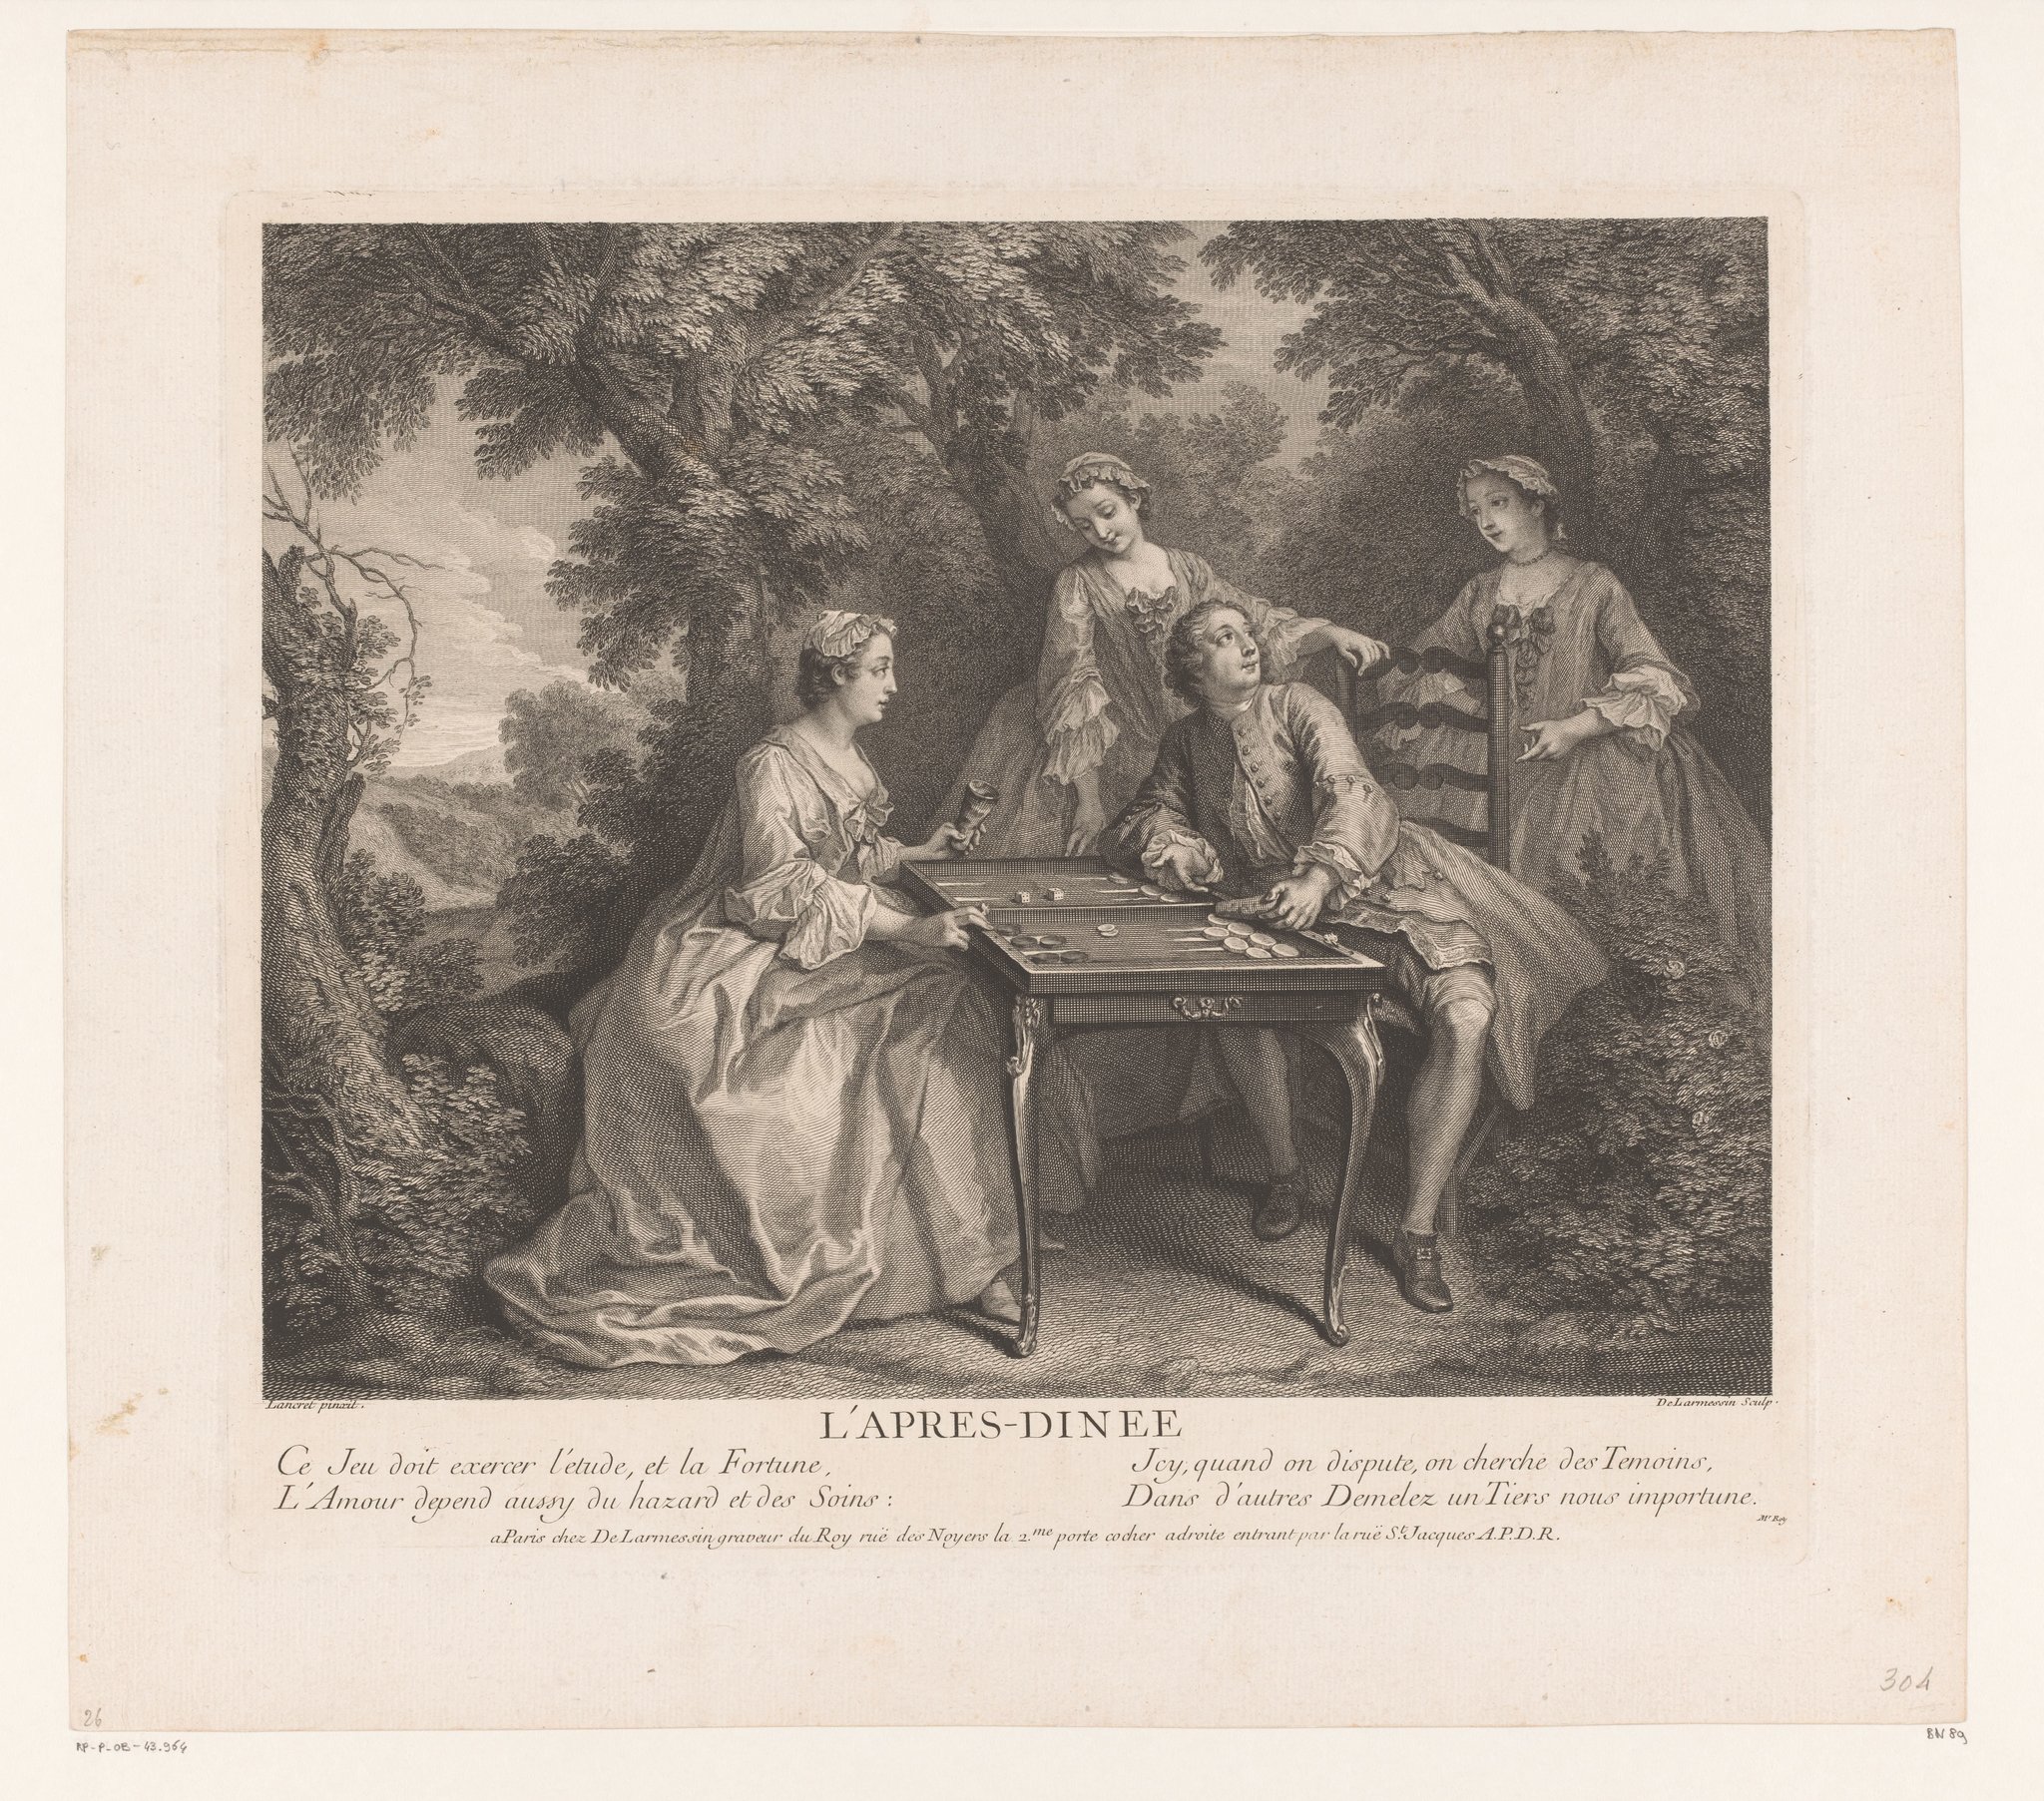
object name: print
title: L'Après-Dinée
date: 1741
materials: paper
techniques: engraving, etching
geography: france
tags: backgammon, tric-trac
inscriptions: collector's mark: Lugt 240, collector's mark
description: Elegante man en vrouw spelen triktrak in een park. Twee vrouwen kijken toe. Met vierregelig gedicht in het Frans.